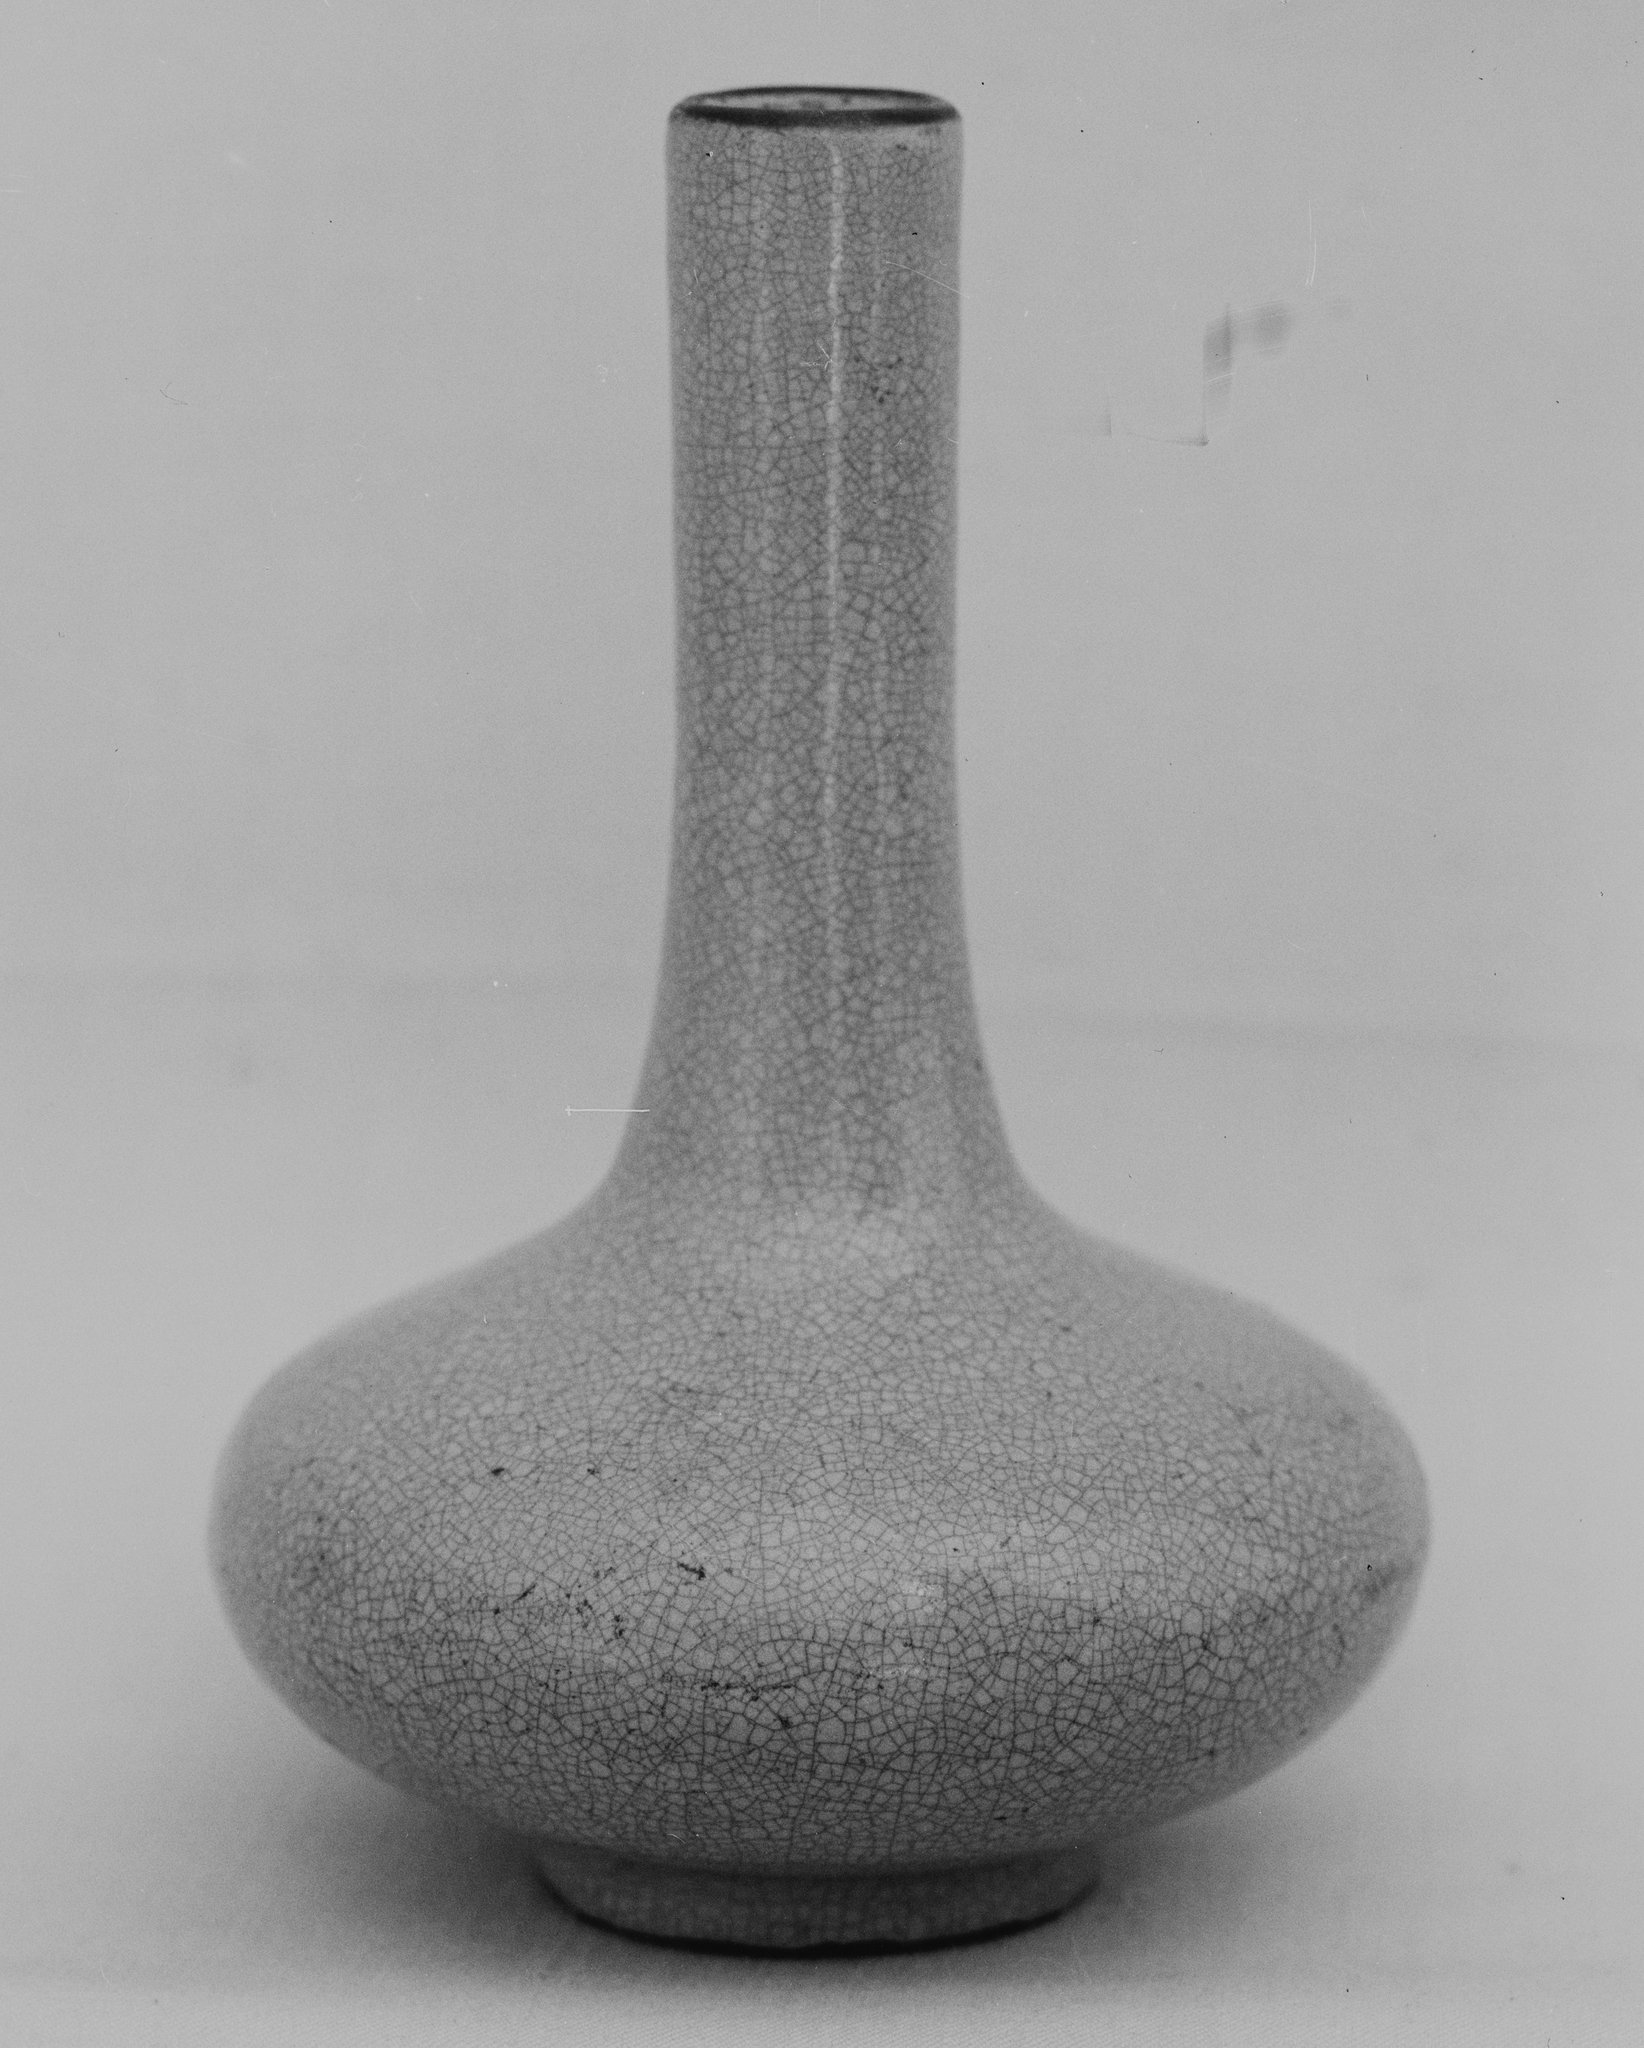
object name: bottle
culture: chinese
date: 1736-1795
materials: porcelain